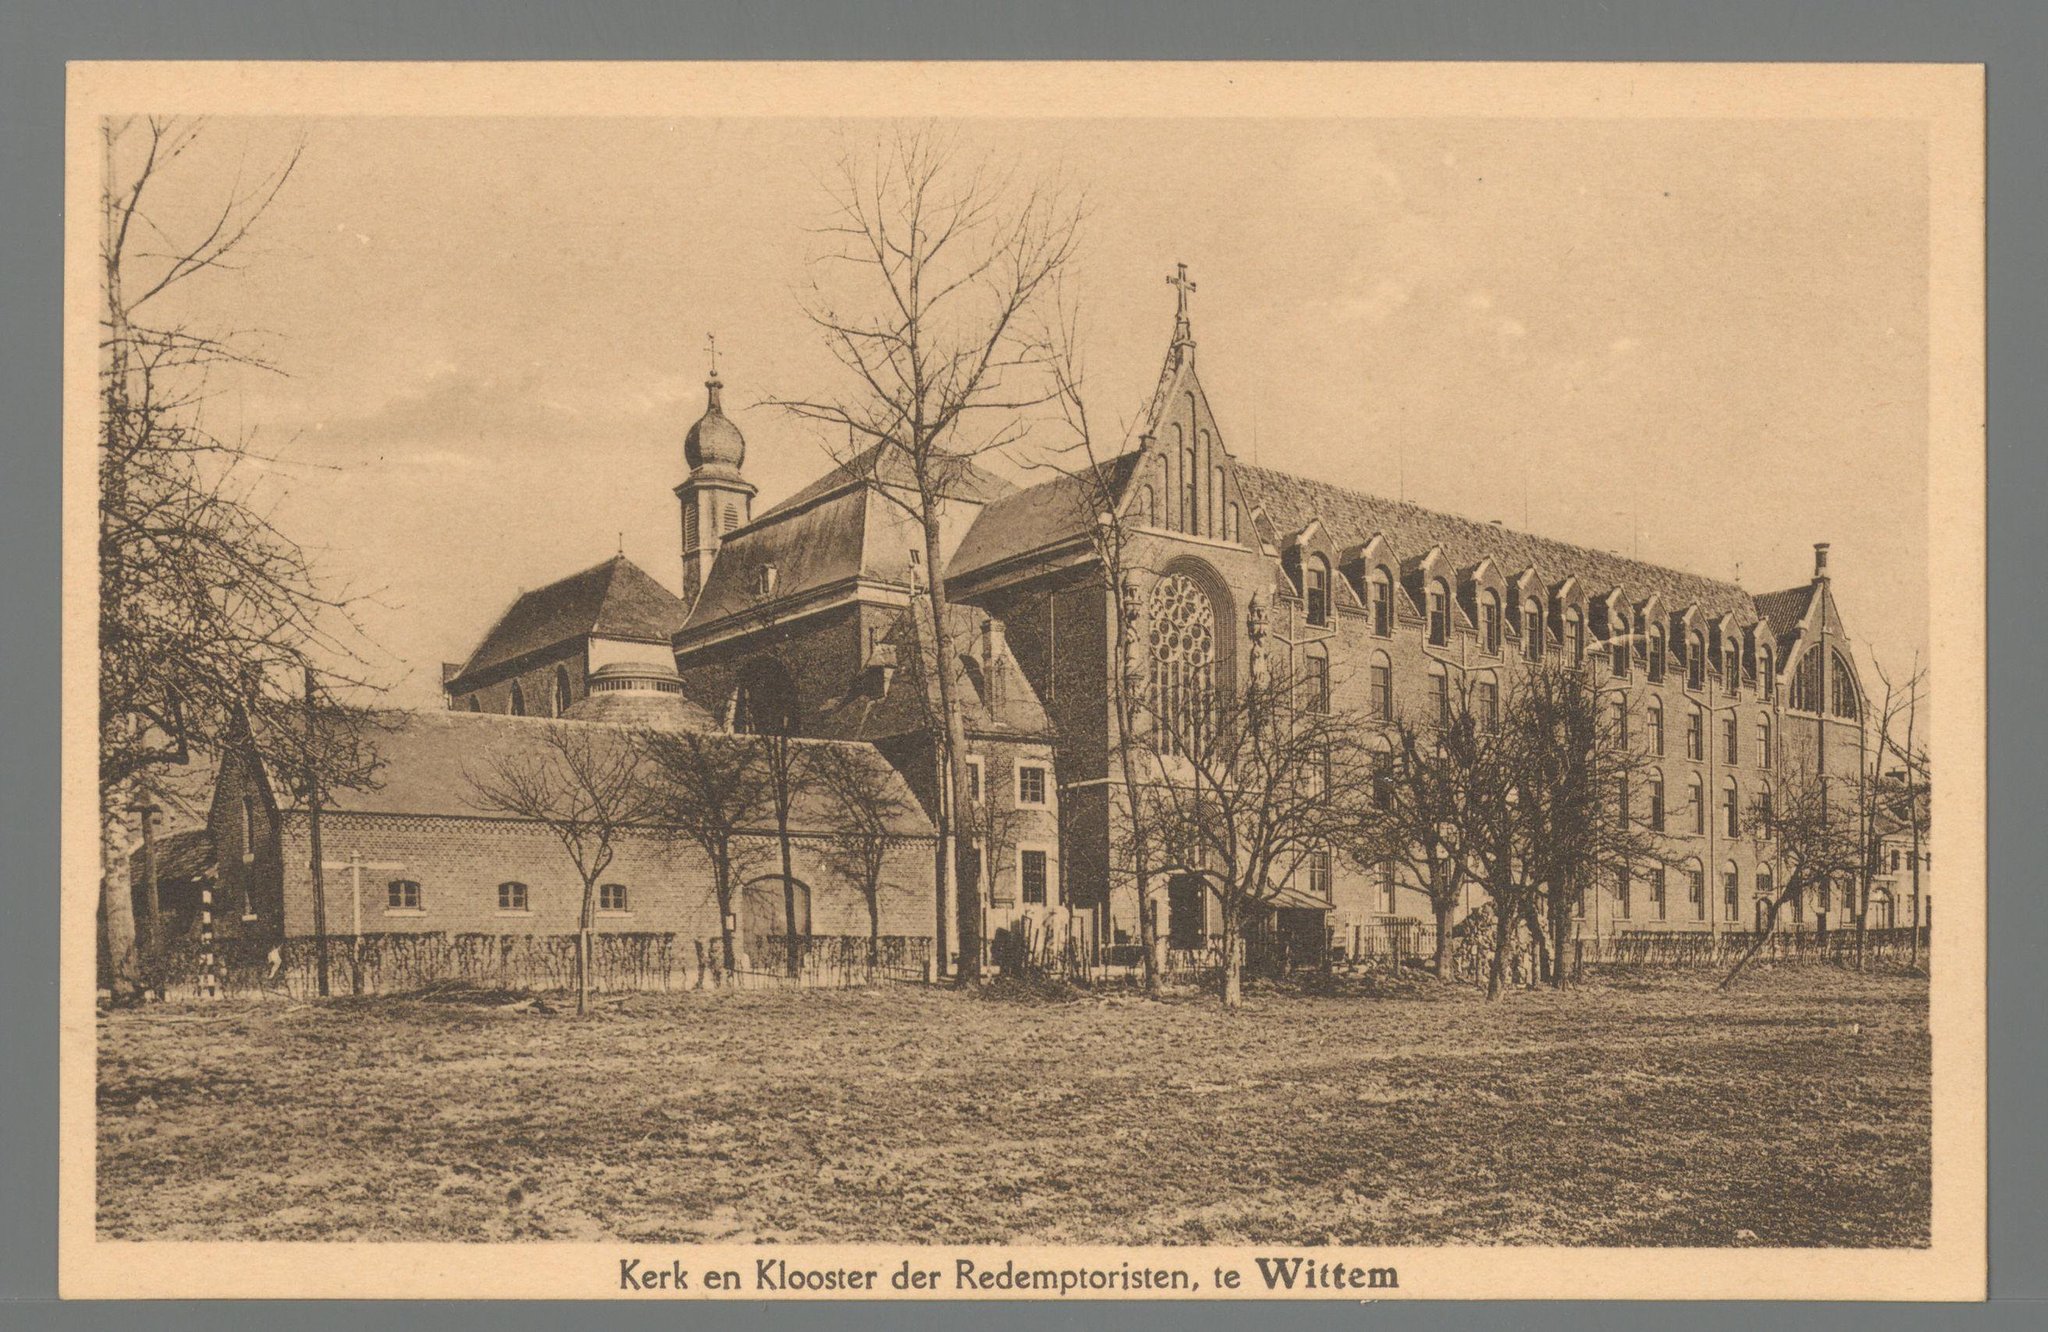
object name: photomechanical print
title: Kerk en klooster der redemptoristen, te Wittem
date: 1913-1935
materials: cardboard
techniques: photograph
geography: wittem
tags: abbey, monastery, convent ~ roman catholic church, church (exterior)